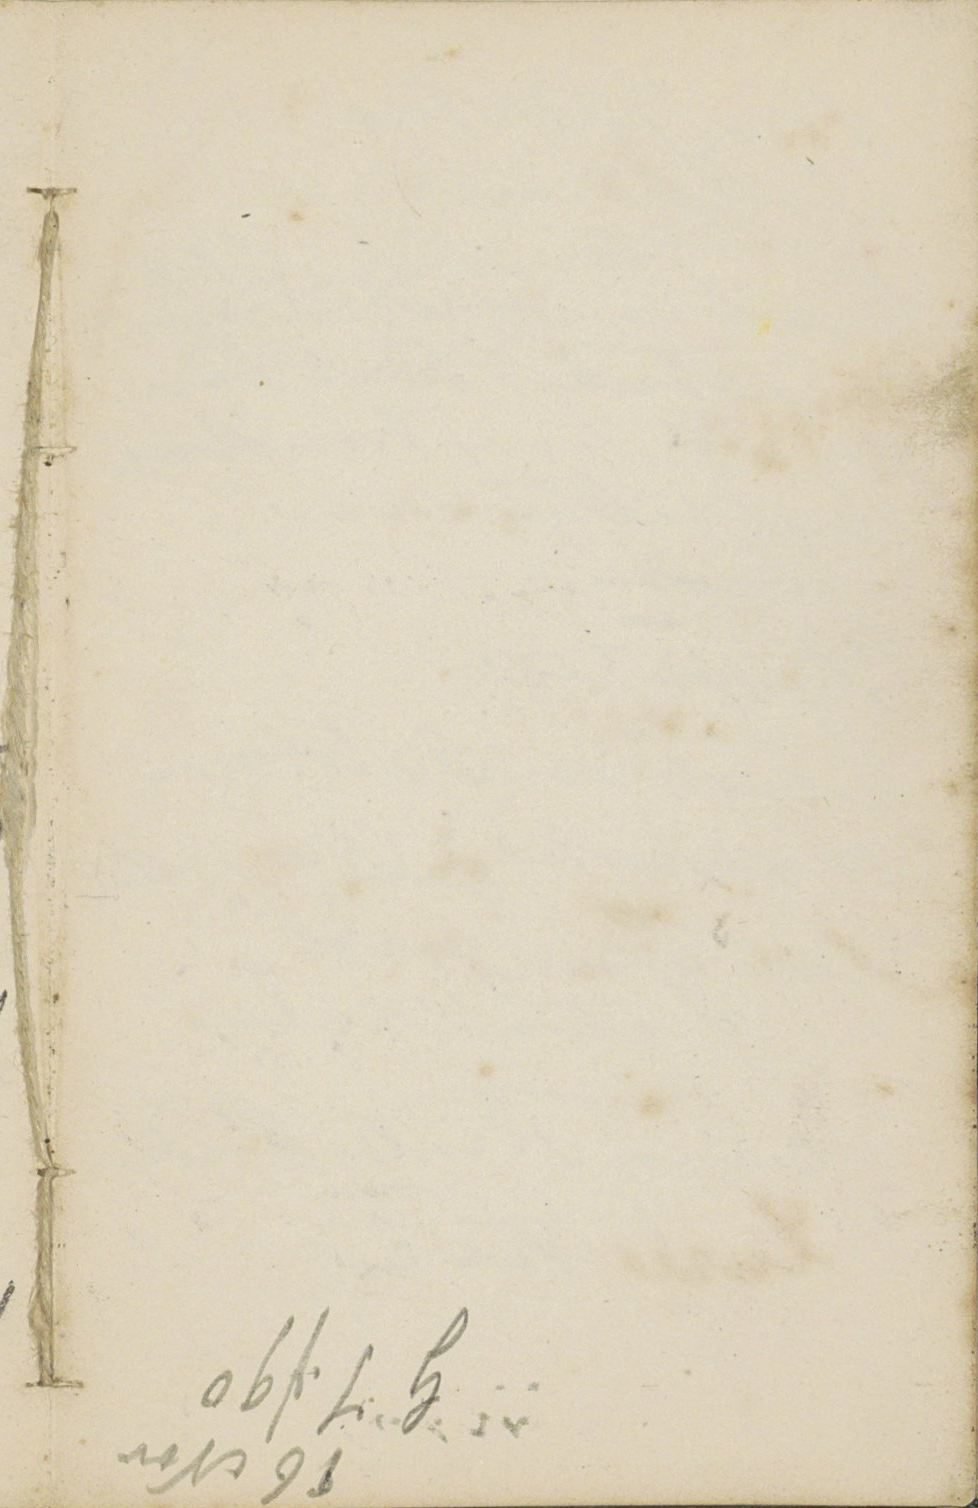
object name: sketchbook leaf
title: Notitie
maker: willem koekkoek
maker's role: draughtsman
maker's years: 1839-1895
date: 1849-1895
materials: paper, pencil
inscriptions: annotation: ‘16 [...]/gJ f90’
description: Blad 56 recto uit een schetsboek met 57 bladen.